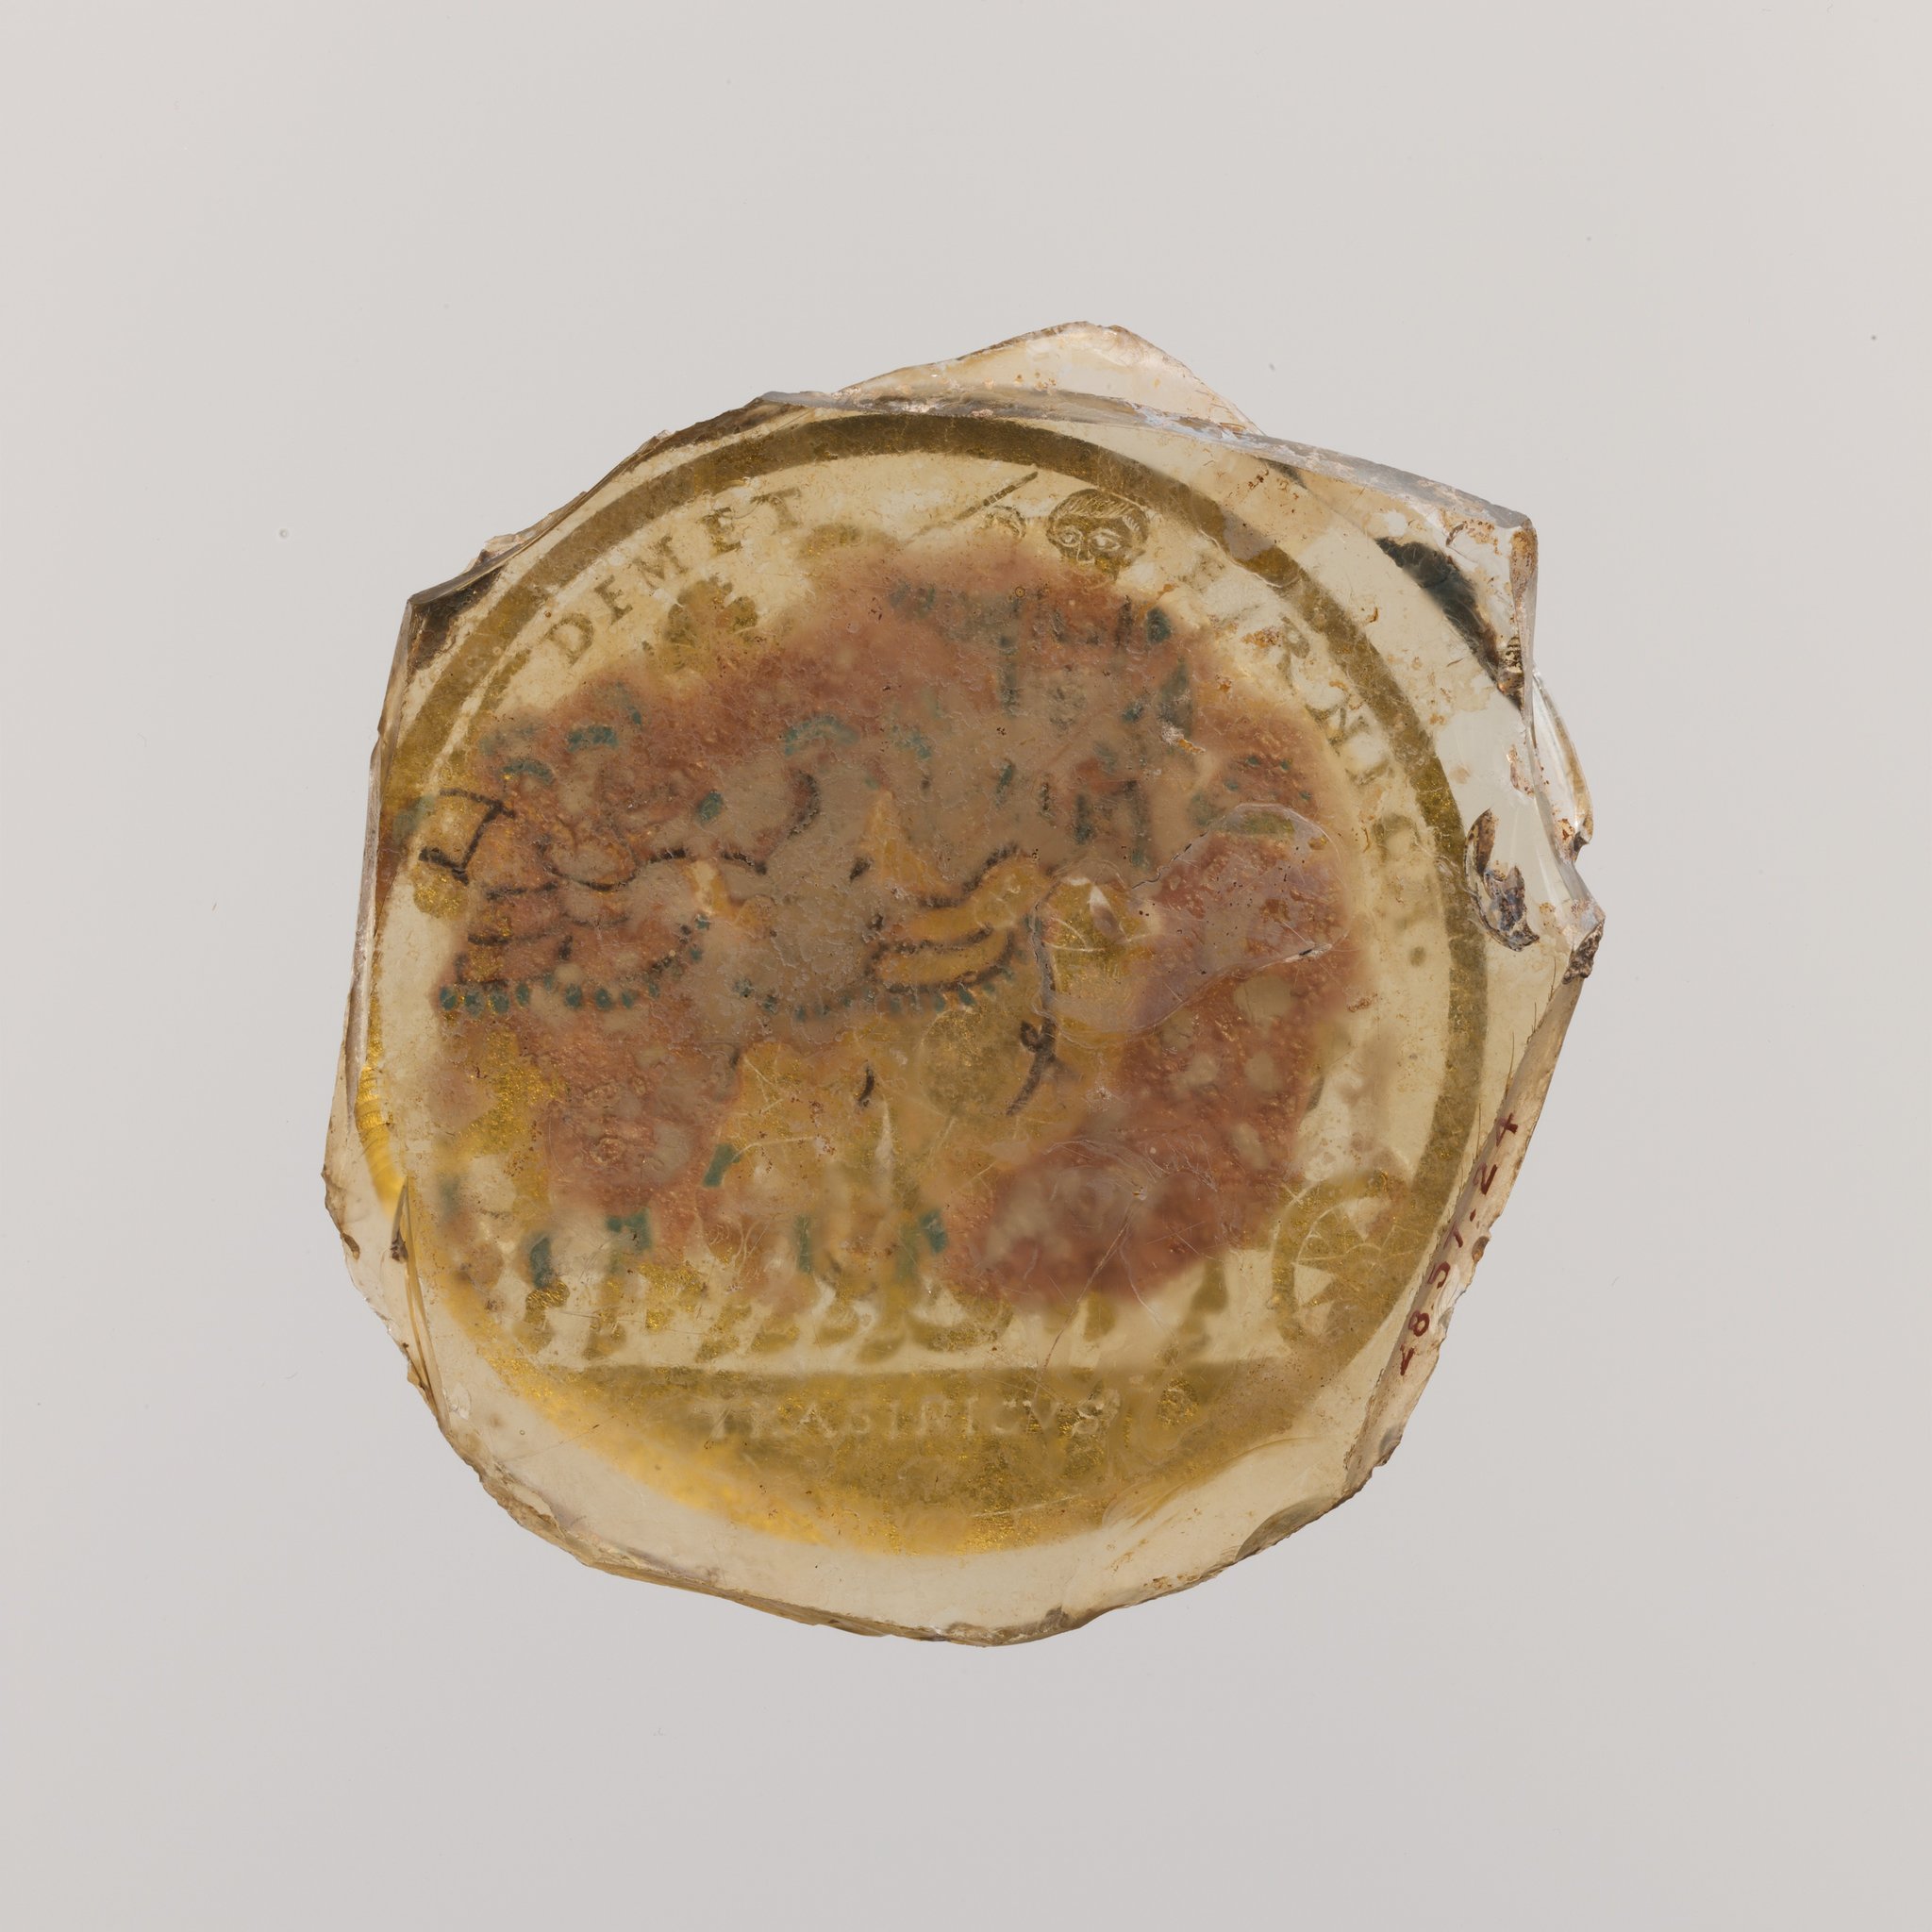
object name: beaker fragment, base medaillion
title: Gold glass base of a beaker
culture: roman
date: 201-300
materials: glass, gold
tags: horses,chariots